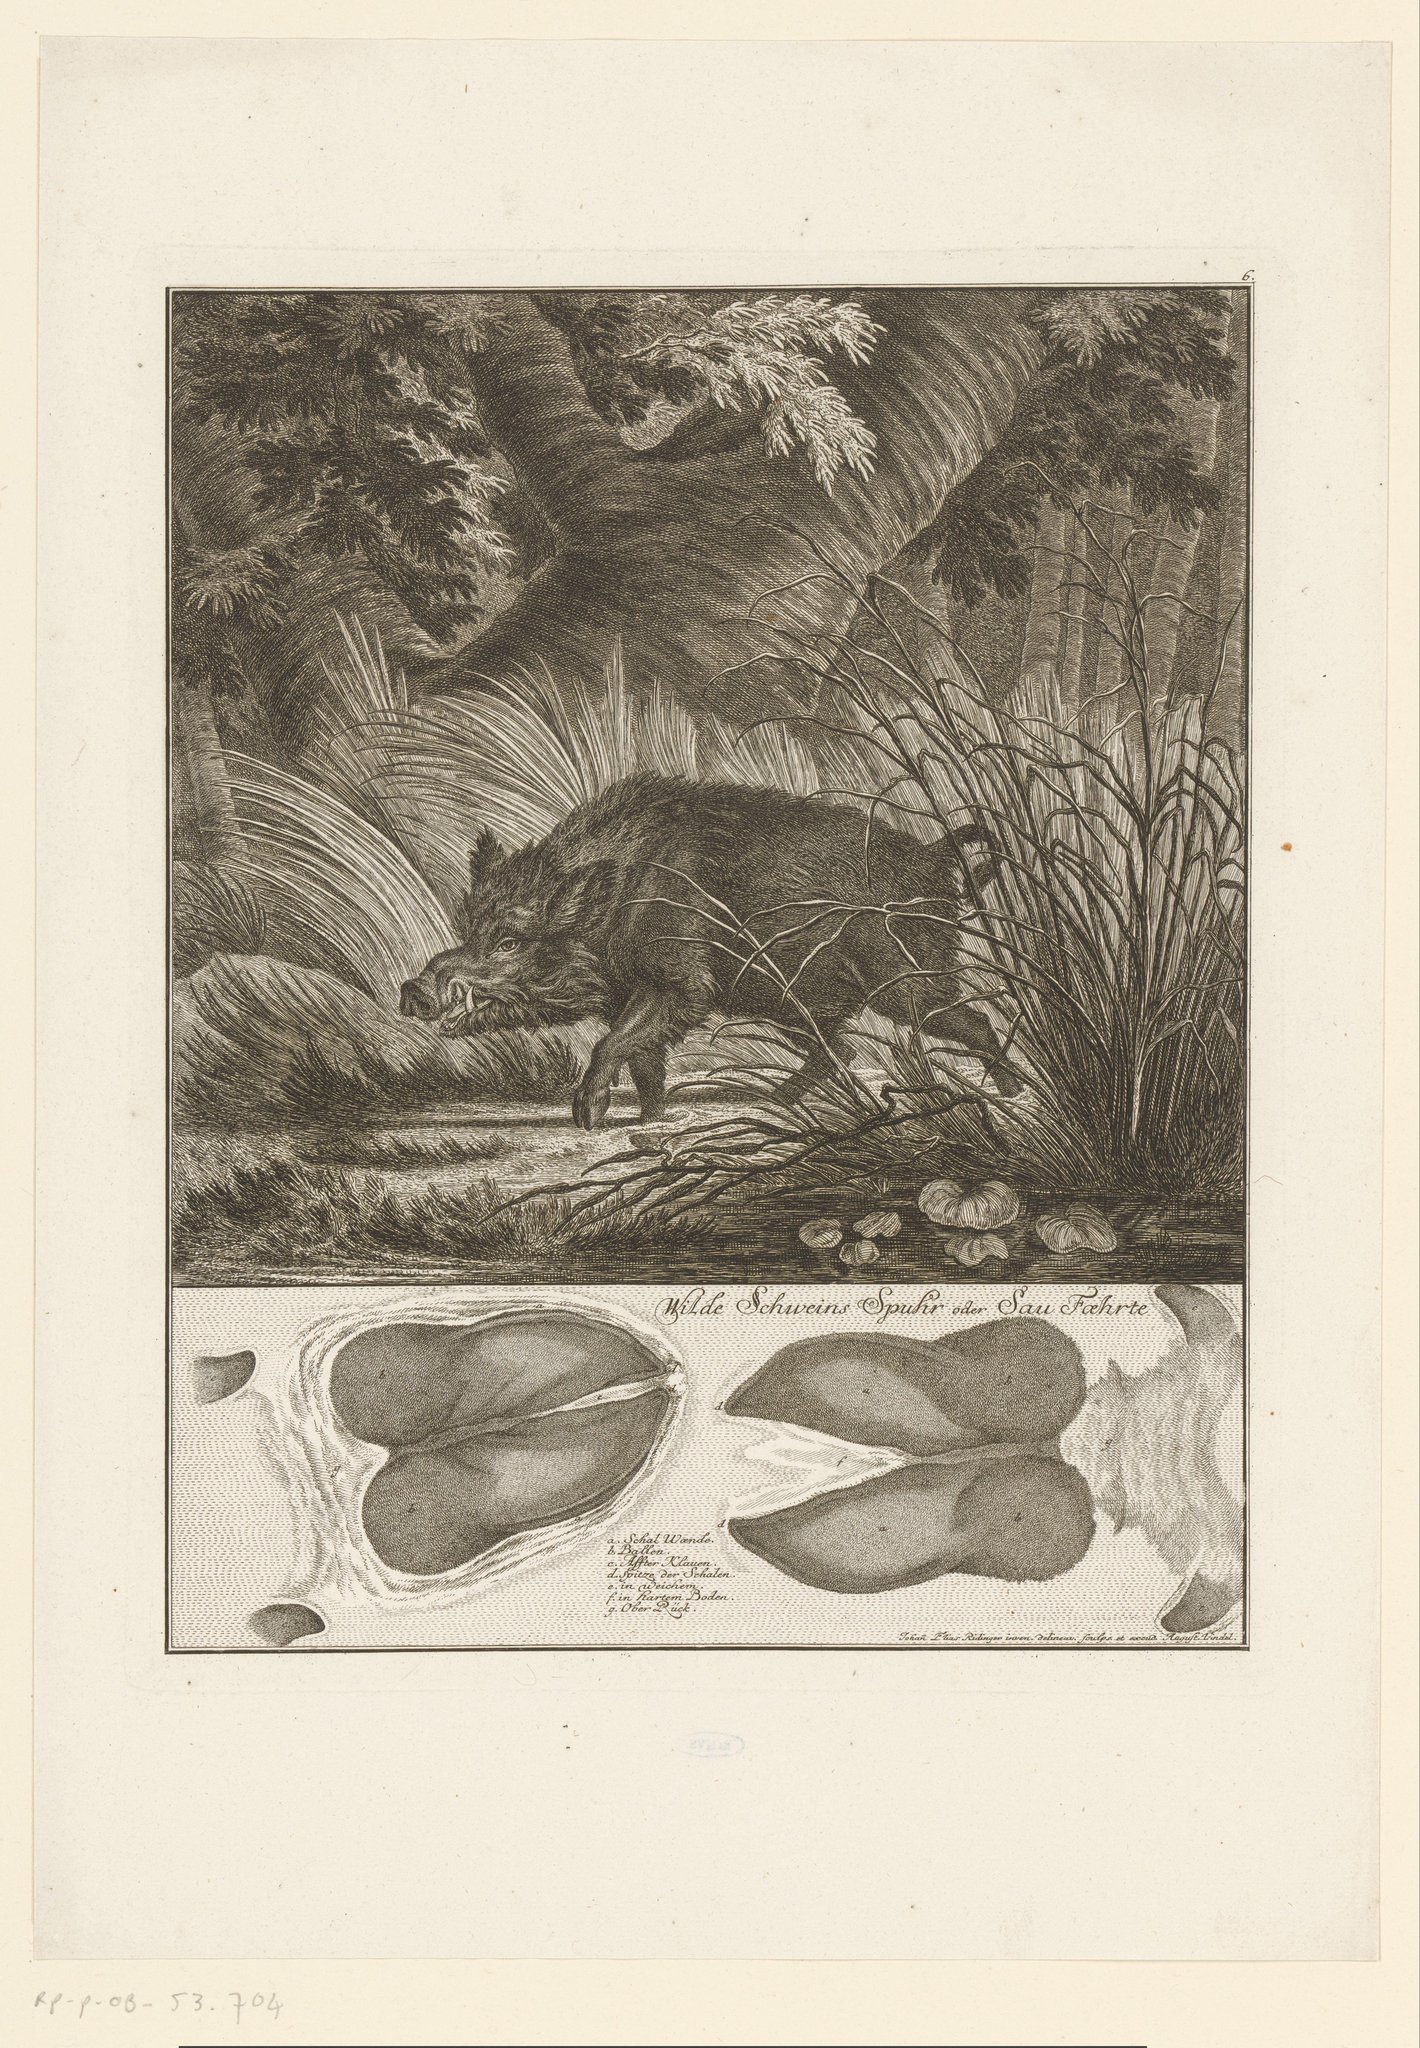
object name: print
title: Dieren met hun sporen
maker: johann elias ridinger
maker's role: draughtsman, painter, print maker, publisher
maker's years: 1698-1767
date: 1751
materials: paper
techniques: etching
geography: augsburg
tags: foot-print, track, hoofed animals: boar, forest, wood, hunt ~ mammals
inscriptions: collector's mark: Lugt 2228